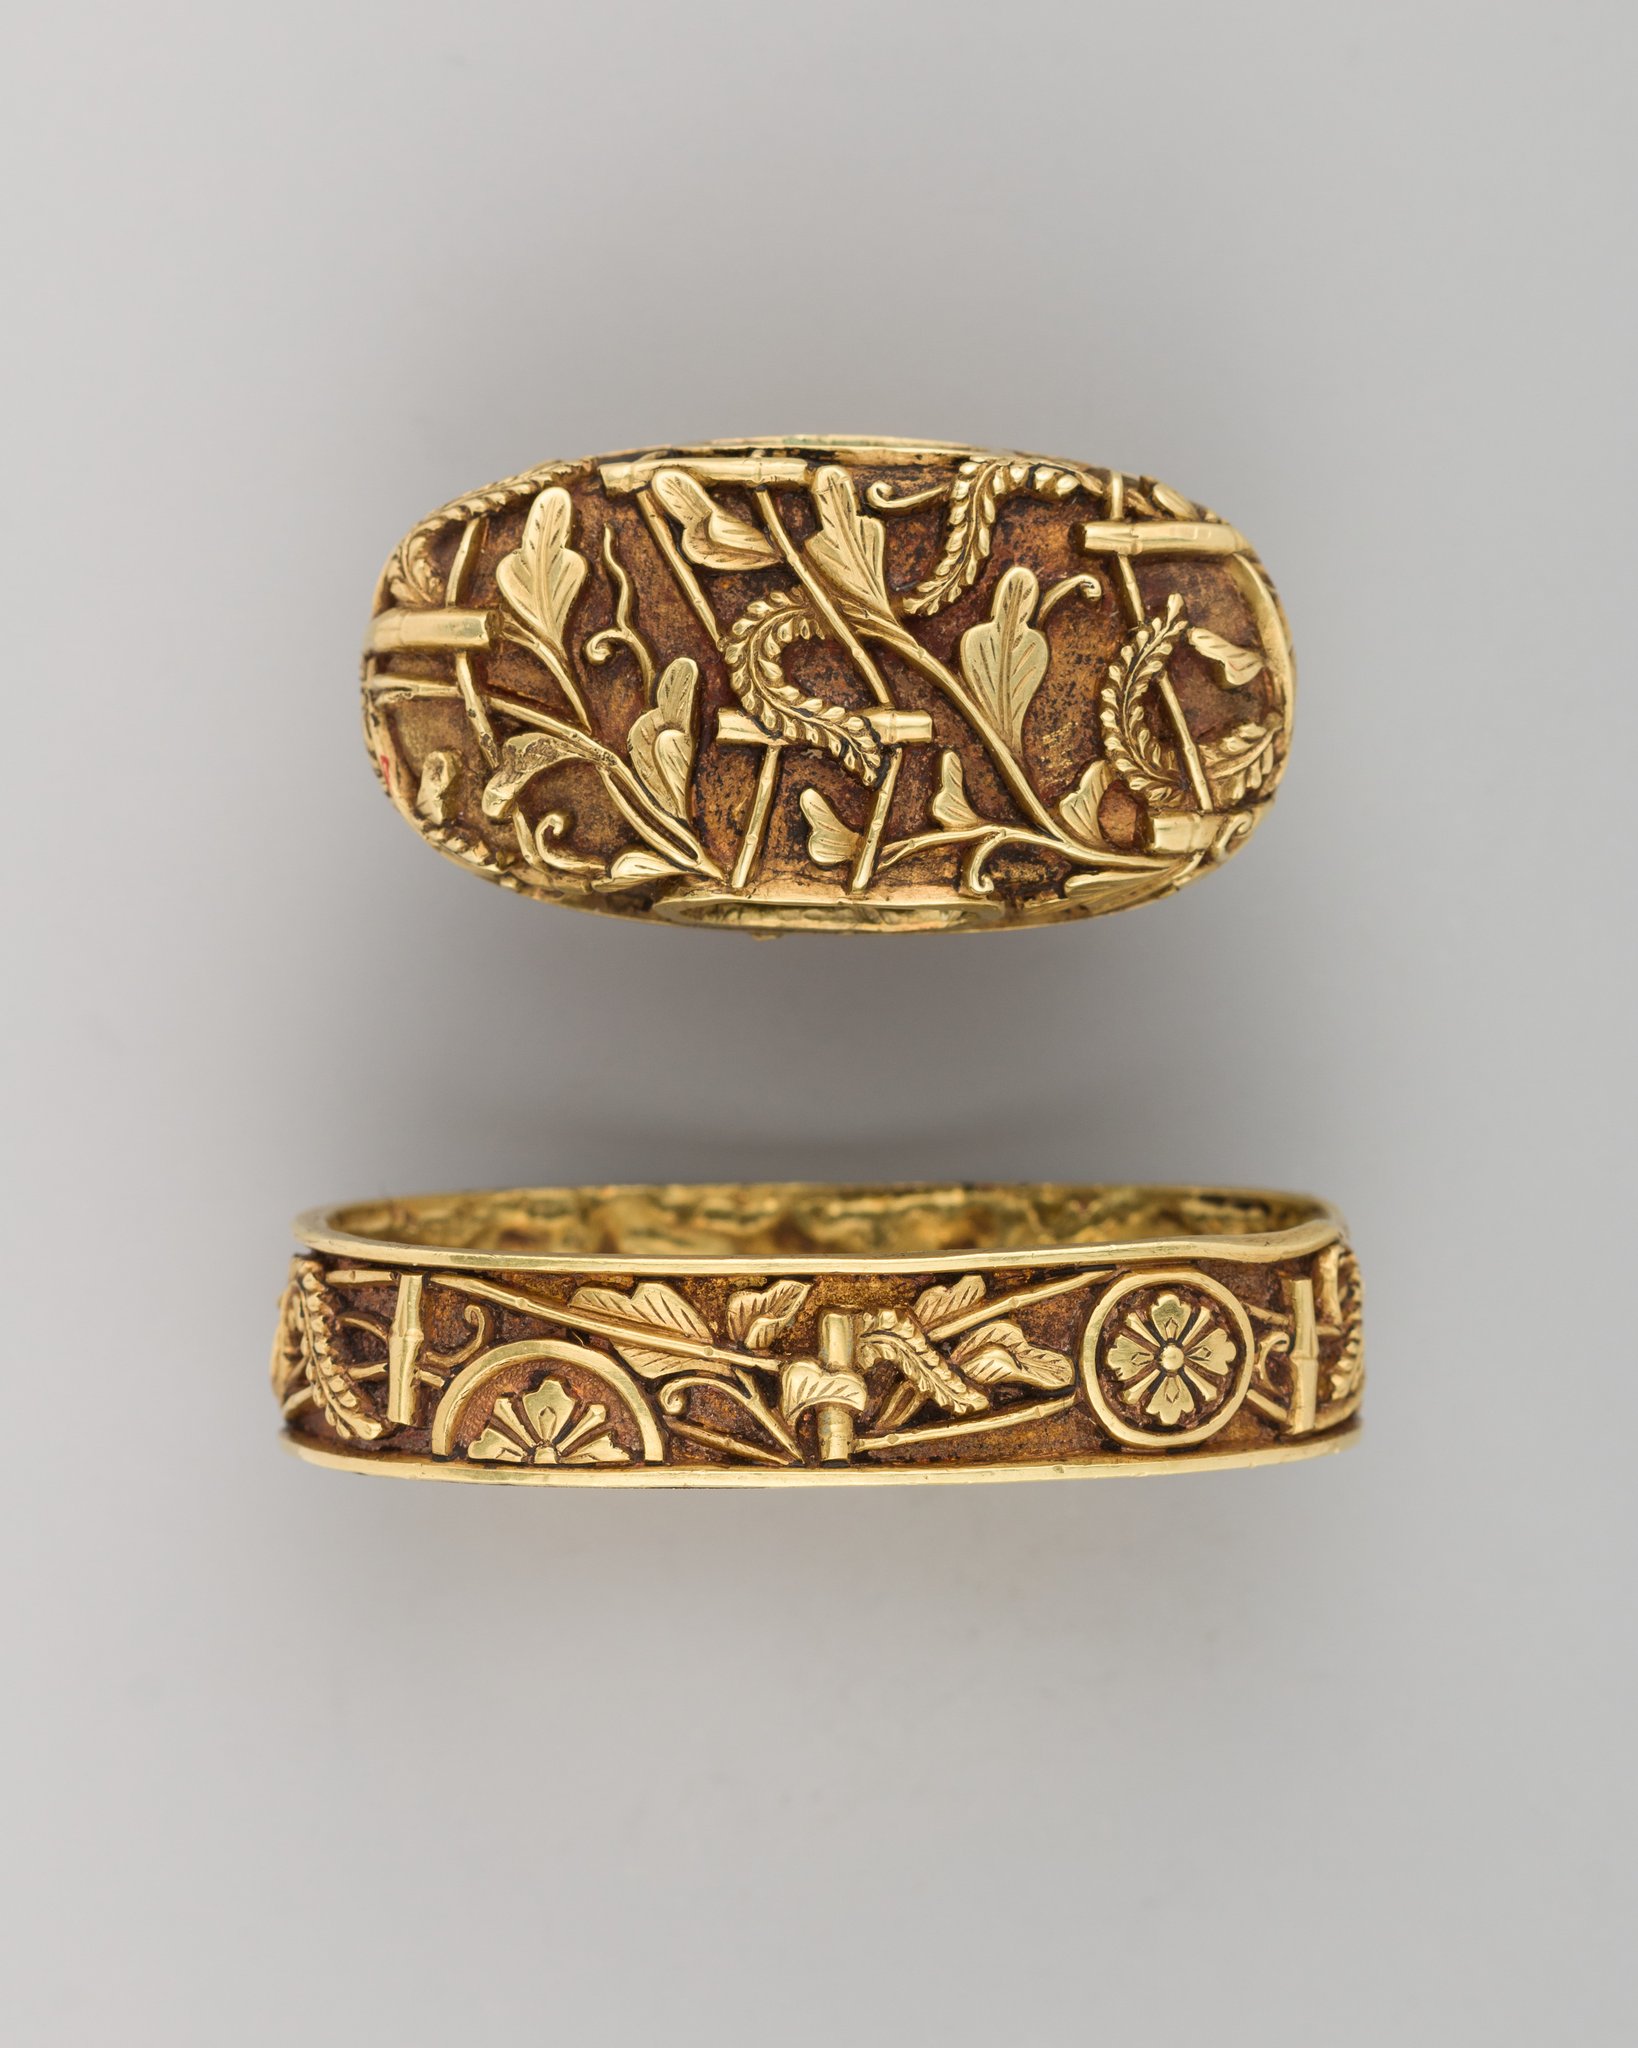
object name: sword hilt collar and pommel fuchigashira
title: Sword-Hilt Collar and Pommel (Fuchigashira)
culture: japanese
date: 1501-1600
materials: copper, gold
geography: japan